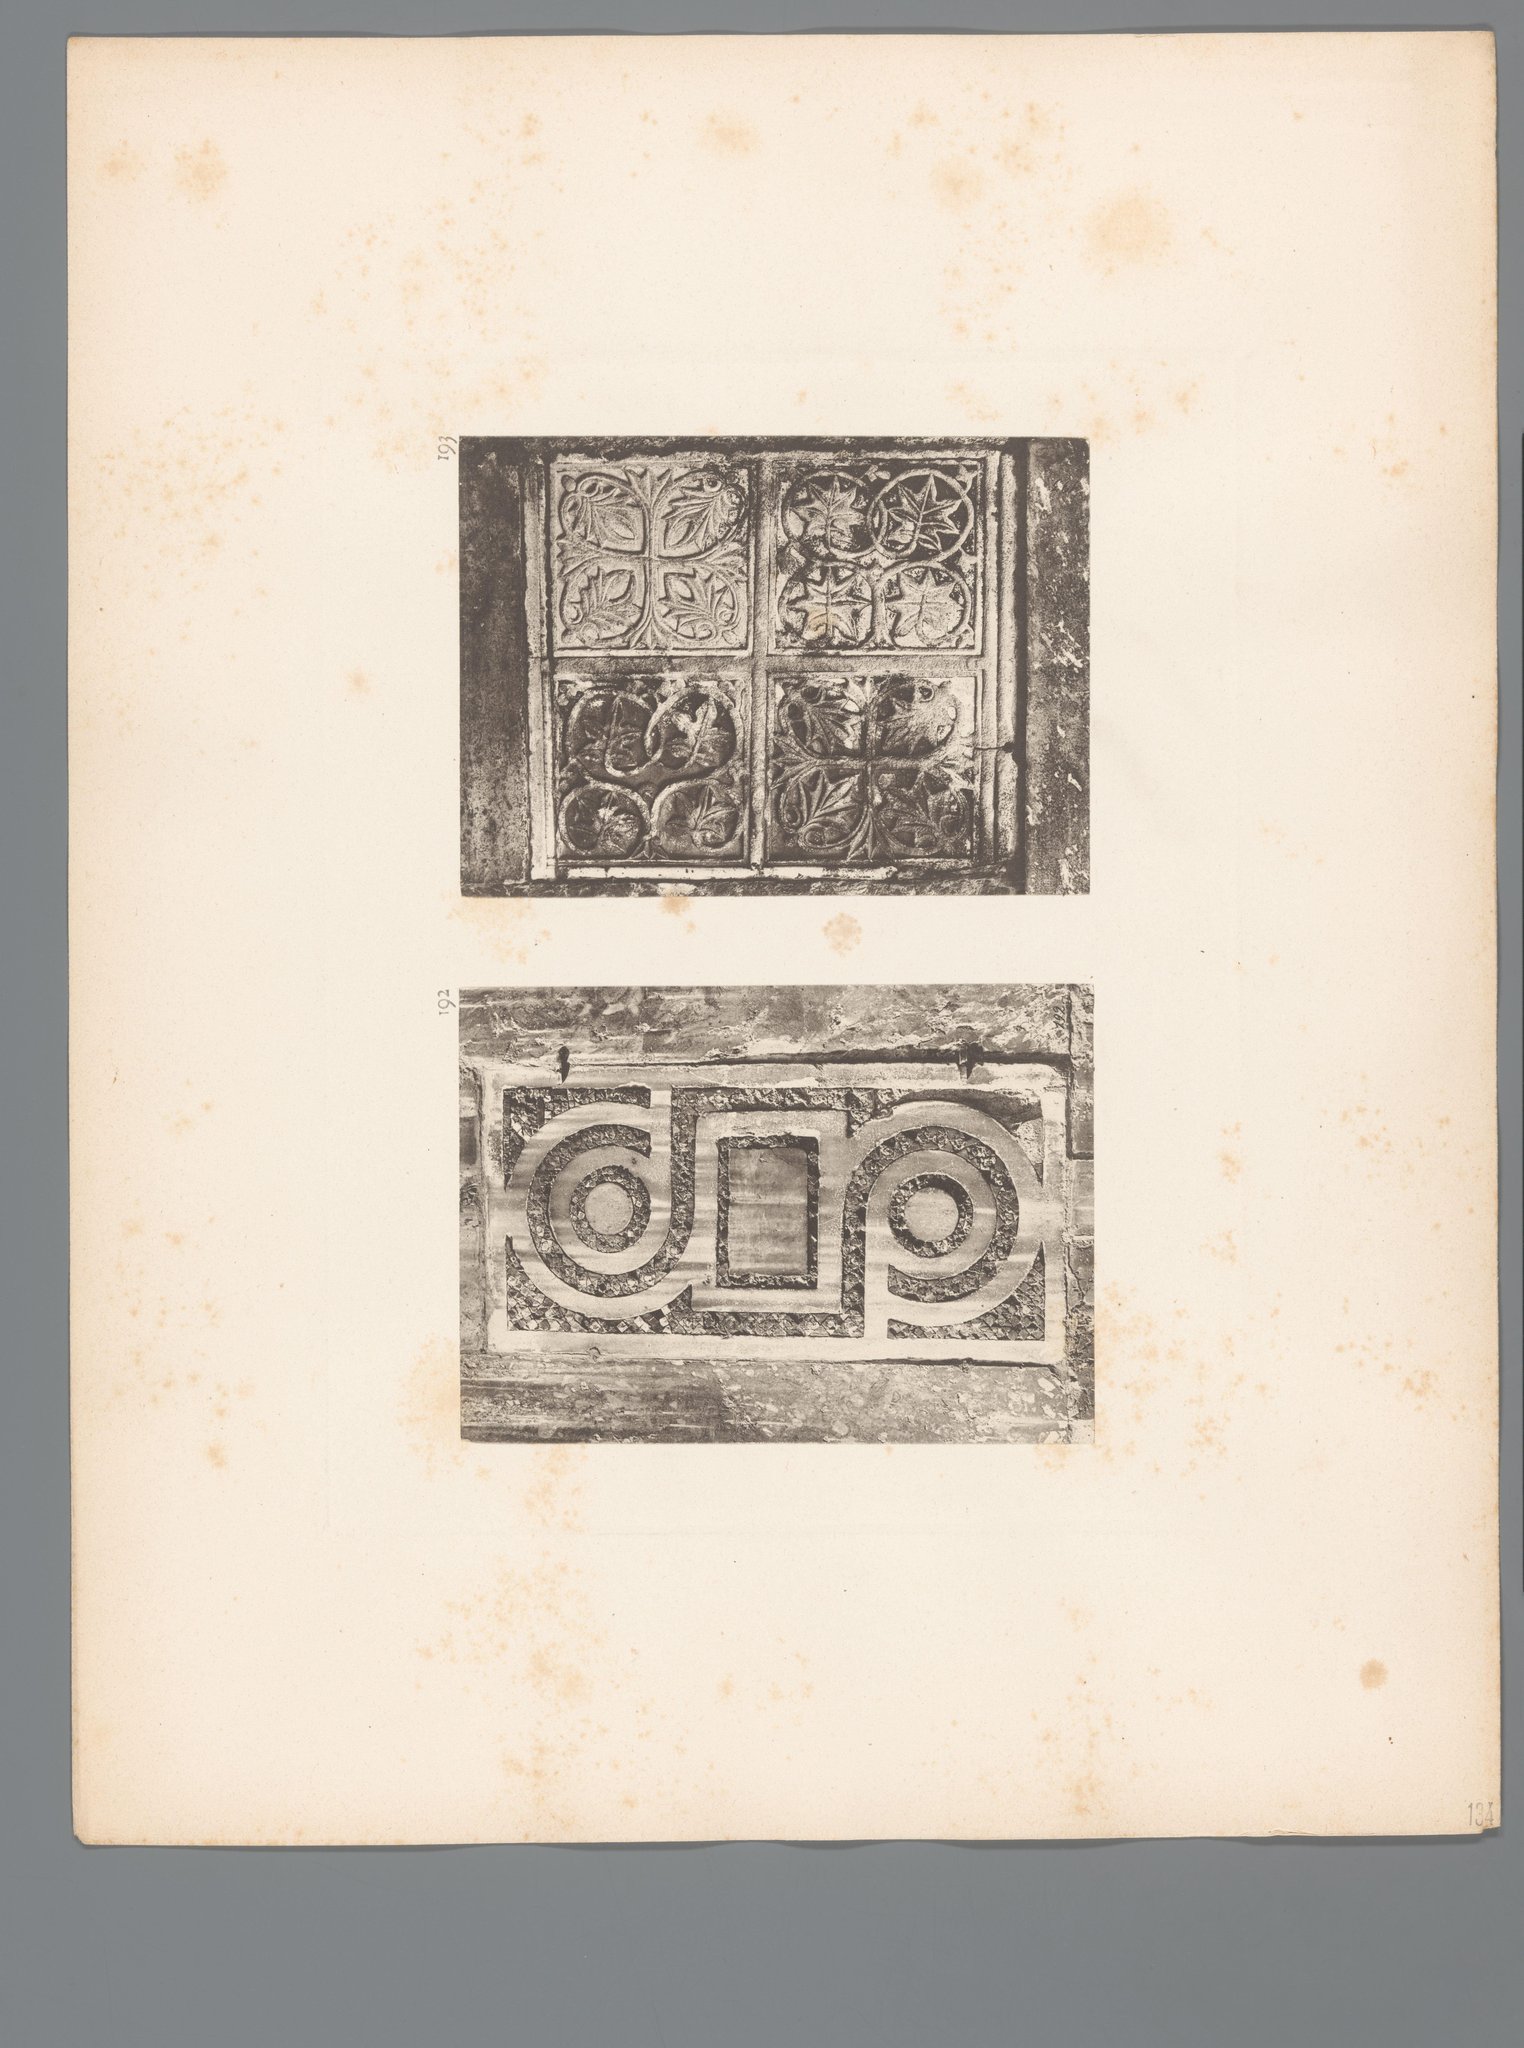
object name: photomechanical print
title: Twee details van het exterieur van de San Marco in Venetië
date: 1879-1884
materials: paper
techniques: photograph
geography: venice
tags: church (exterior), piece of sculpture, reproduction of a piece of sculpture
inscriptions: number: ‘192’, number: ‘193’, number: ‘134’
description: Deze prent maakt deel uit van een omslag met 51 prenten op 29 bladen en 1 tekstblad.